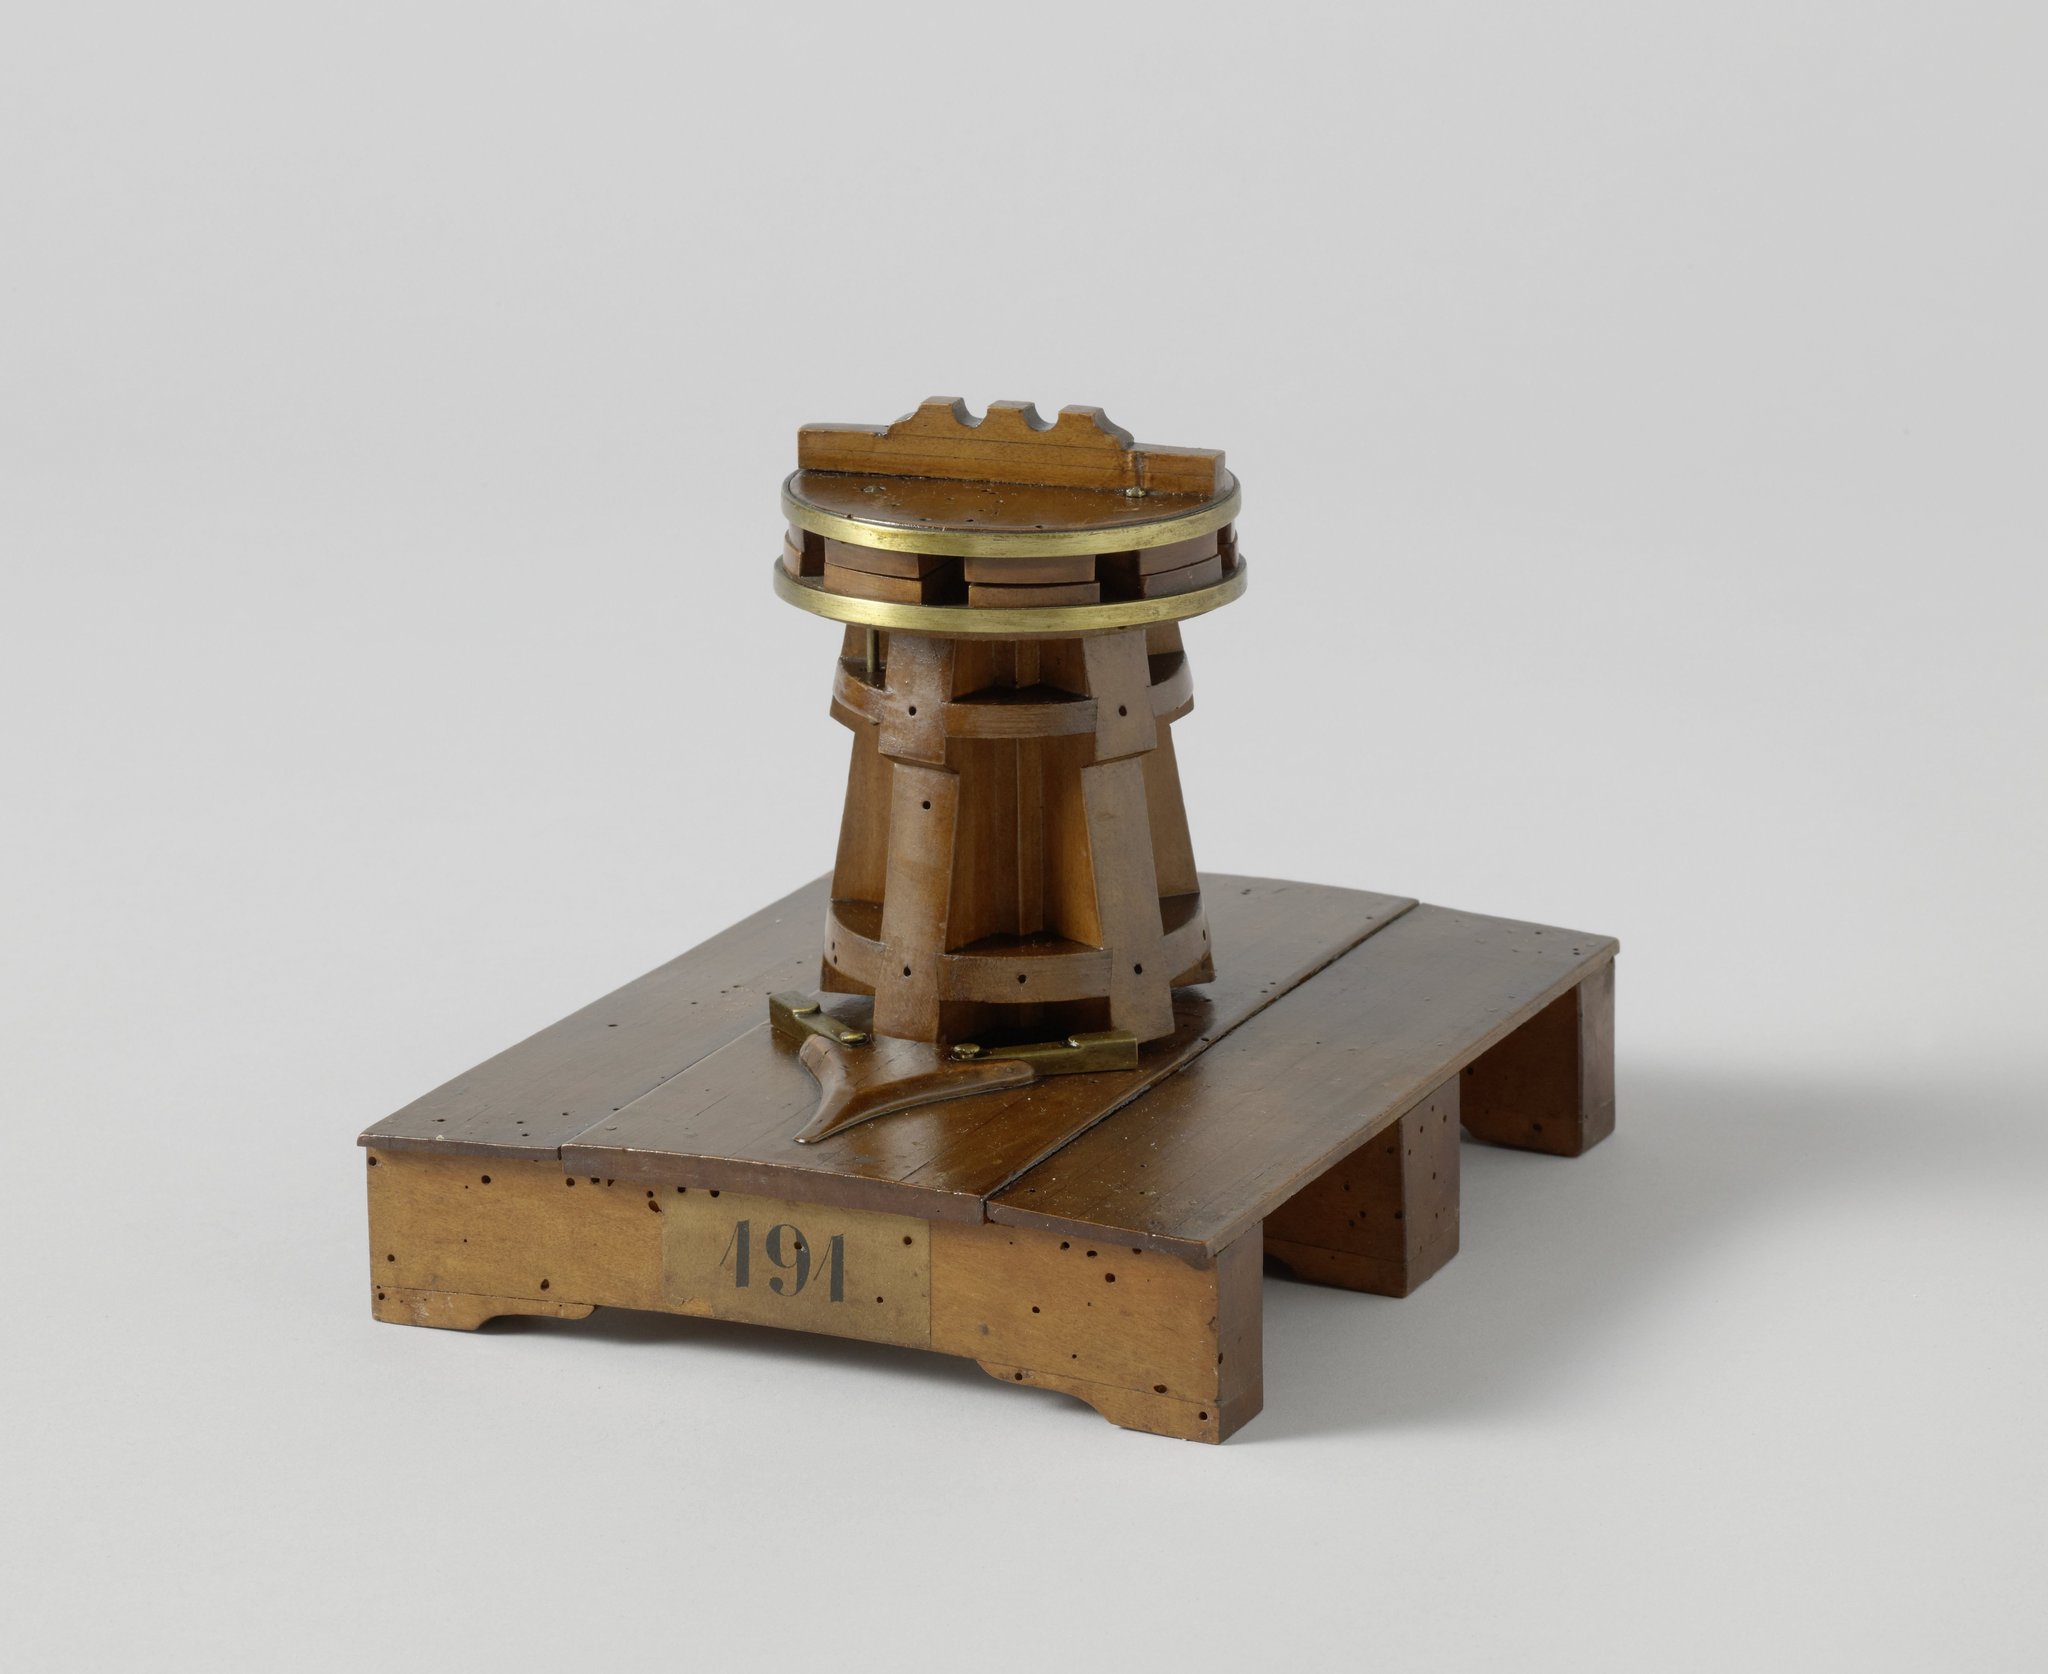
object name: demonstration model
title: Model of a Capstan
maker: Anonymous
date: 1750-1800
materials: brass, wood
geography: netherlands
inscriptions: label, on the front: ‘191’ former inventory label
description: Model van een kaapstander op een houten vloer. Het is een kaapstander voor acht windbomen; twee pallen in de vloer voorkomen het teruglopen, een voor elke draairichting. De trommel heeft vijf kiezen in de vorm van een flauwe Z, die beneden en bij de kop opgevuld zijn tot een cirkel. De messing koning zit vast in het dek, de trommel draait eromheen. Drie bouten borgen de dekplaat van de kop, die rust op de afgeronde punt van de koning en de trommel een weinig van de vloer tilt, om de wrijving te minimaliseren. Boven op de dekplaat is een steun voor onbekend gebruik gemonteerd. Schaal 1:15 (schatting).